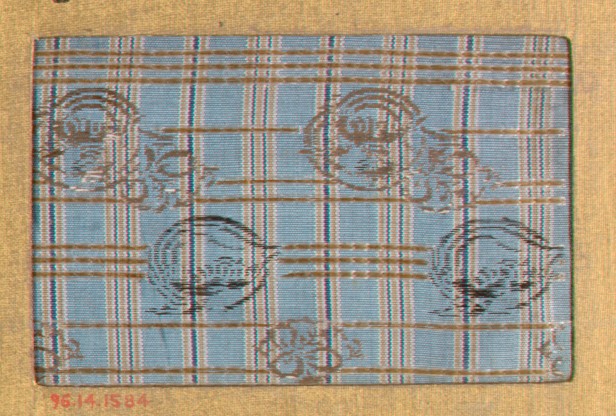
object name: piece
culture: japanese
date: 1701-1900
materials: silk